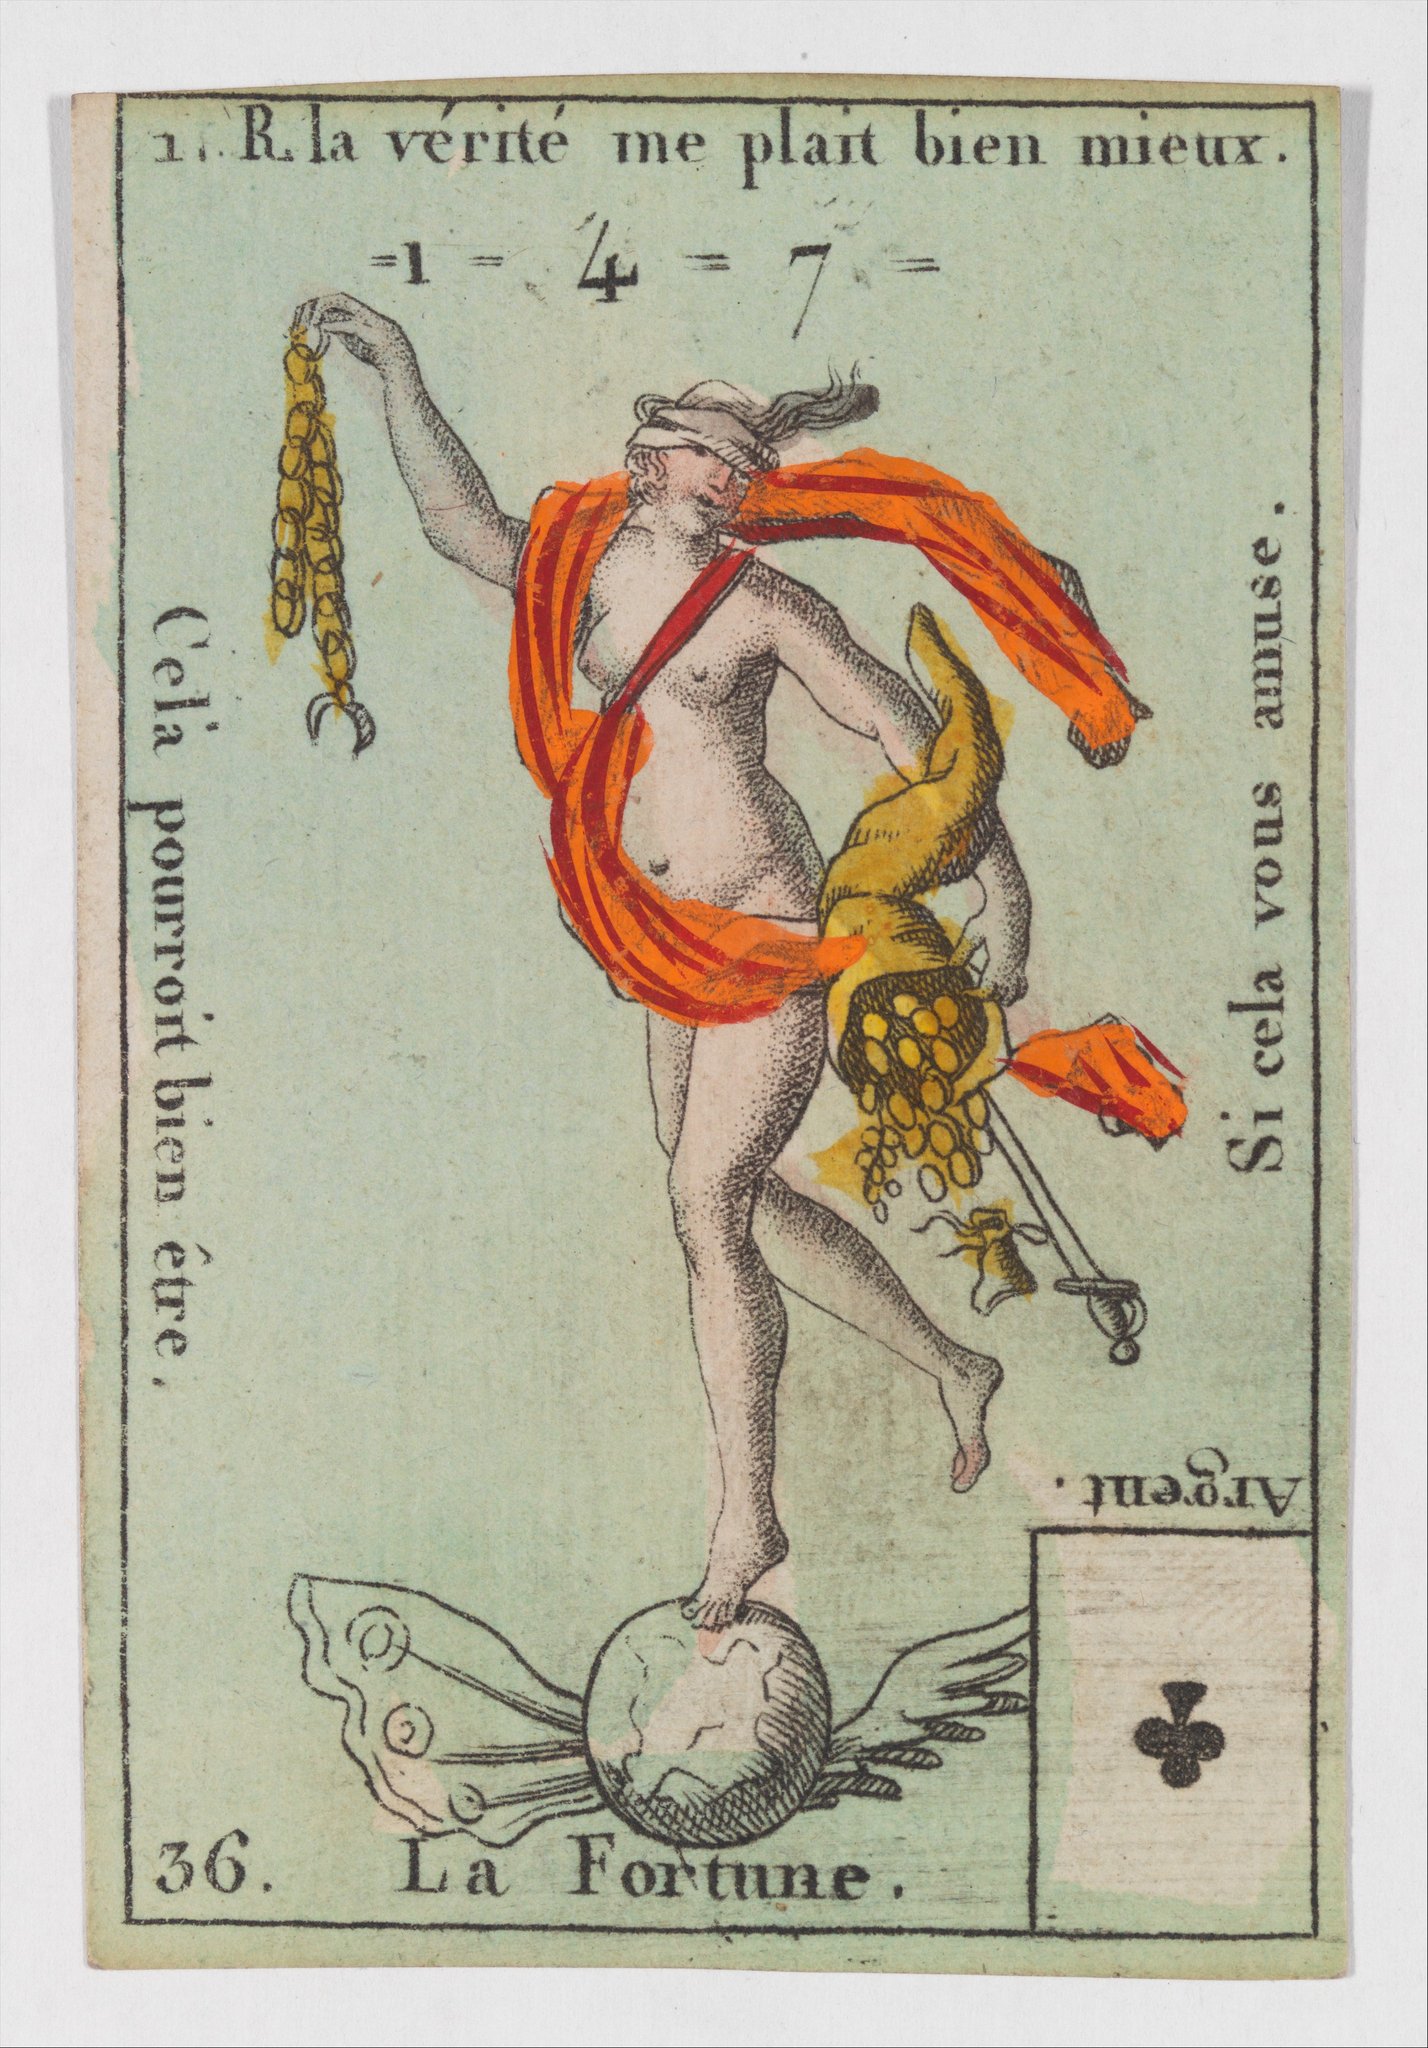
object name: print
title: La Fortune, from the playing cards (for quartets) "Costumes des Peuples Étrangers"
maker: anonymous, french, 18th century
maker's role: artist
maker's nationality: french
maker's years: 1700-1800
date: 1700-1799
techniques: etching, hand coloring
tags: female nudes,playing cards